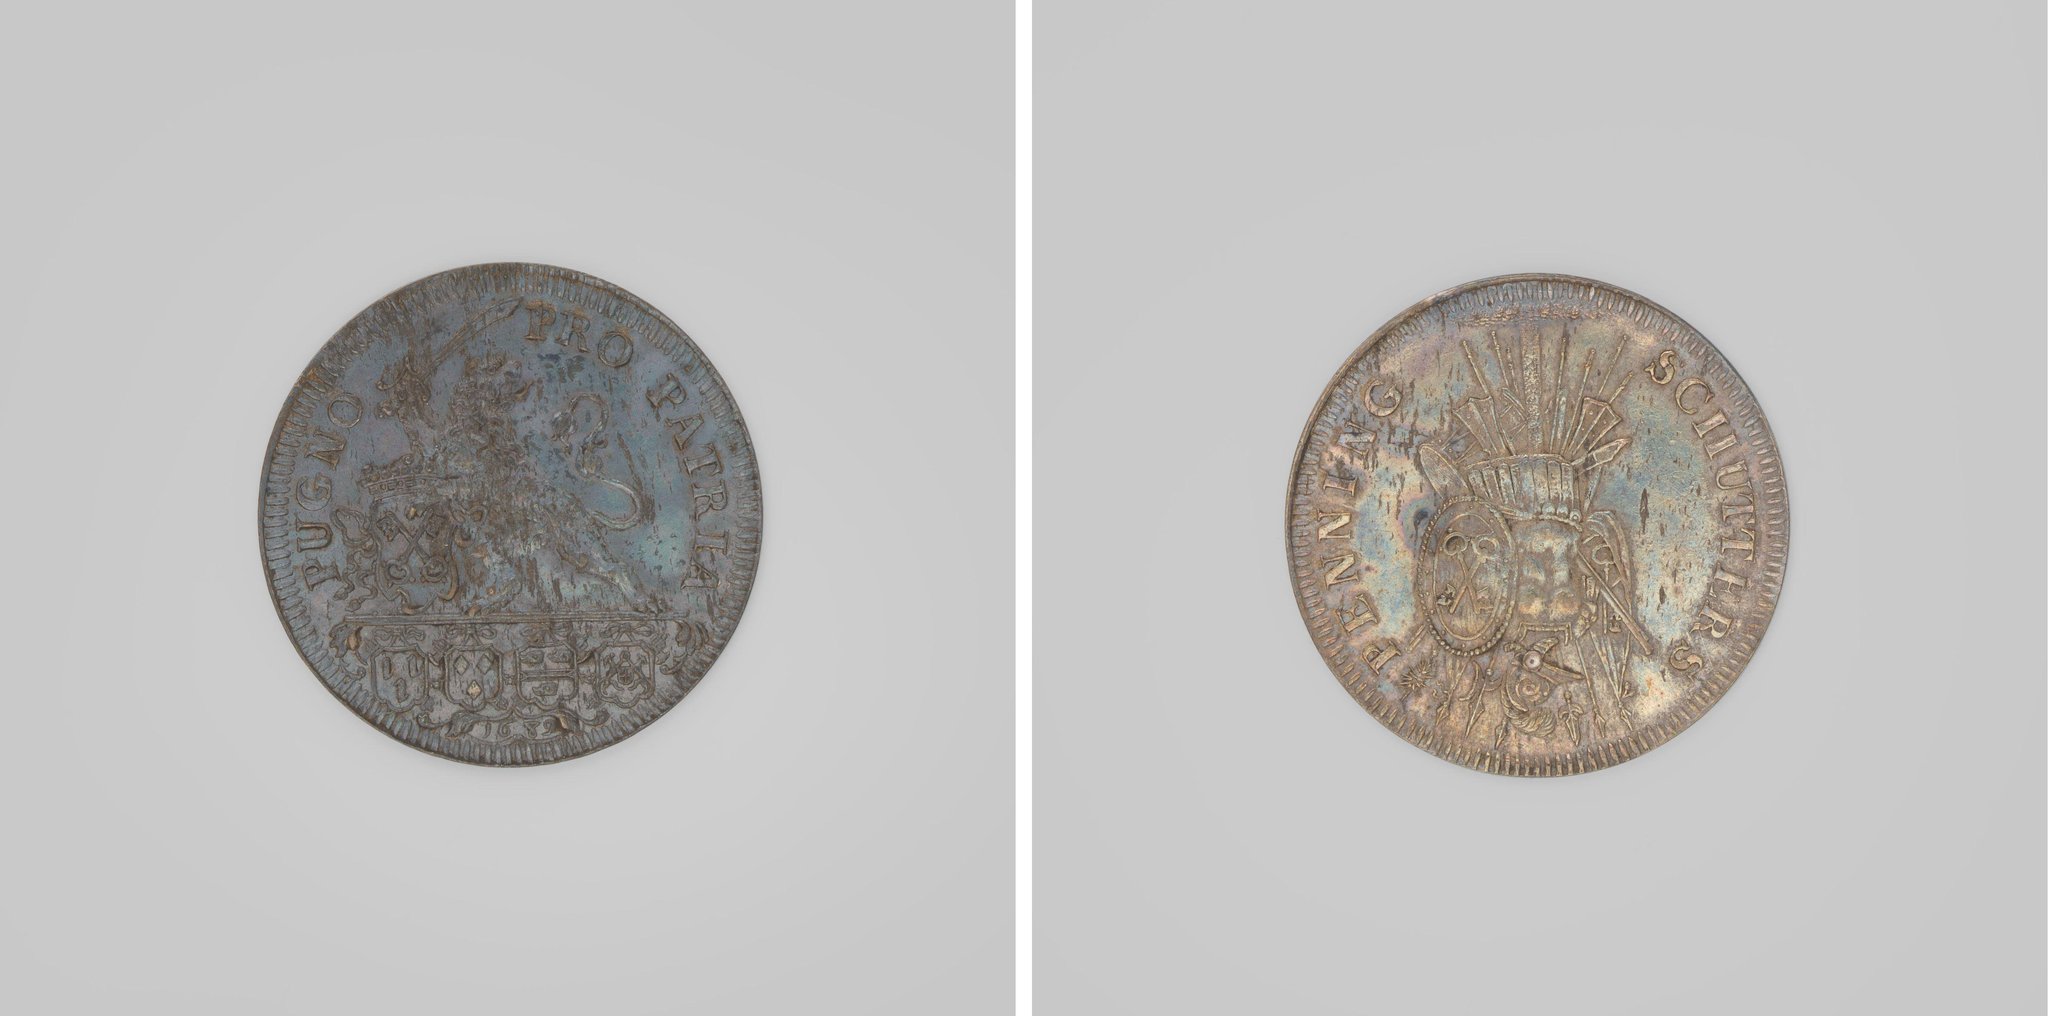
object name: marksman medal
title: Schutterspenning van Leiden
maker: Anonymous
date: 1689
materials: silver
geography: leiden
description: Zilveren schutterspenning van Leiden. Voorzijde: een omziende, klimmende leeuw met een zwaard in zijn rechter en een schild met het Leidse stadswapen in zijn linker klauw. Daaronder de wapens van de vier burgemeesters van Leiden met onderaan het jaartal. Omschrift: PVGNO PRO PATRIA (ik vecht voor het vaderland). Keerzijde: trofeeën. Omschrift: SCHVTTERS PENNING.